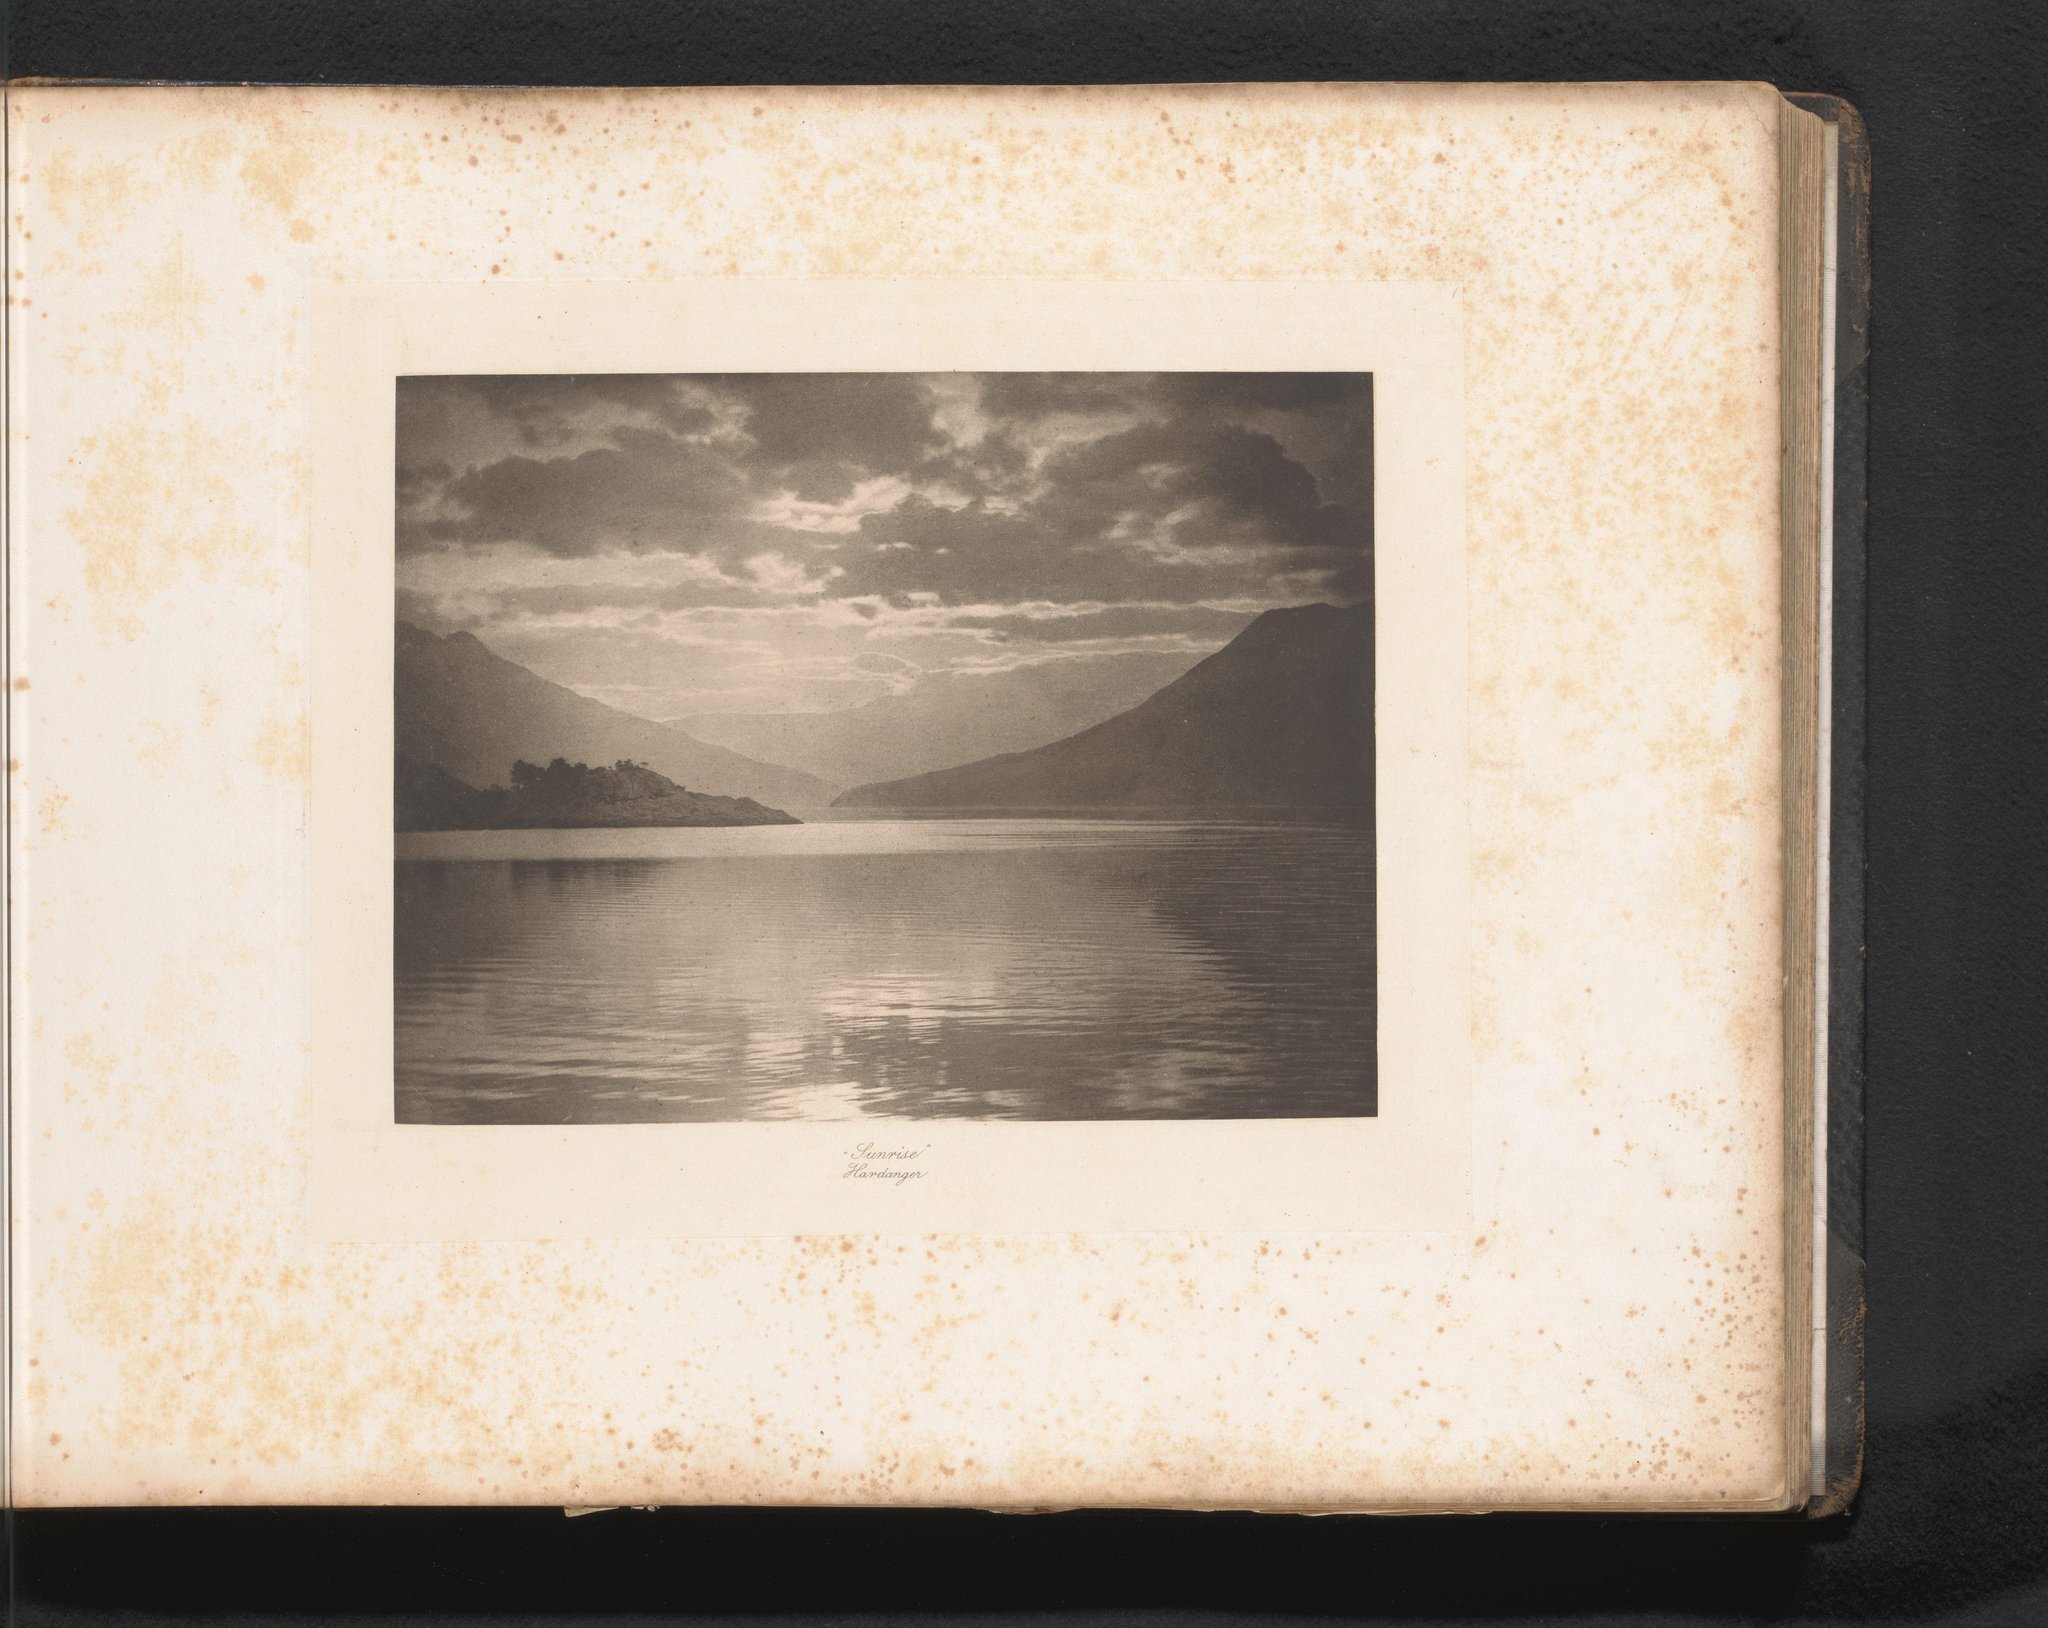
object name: page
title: Gezicht op het Hardangerfjord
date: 1888-1893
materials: paper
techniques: photograph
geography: hardangerfjord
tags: fjord, sea loch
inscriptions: number: ‘1’